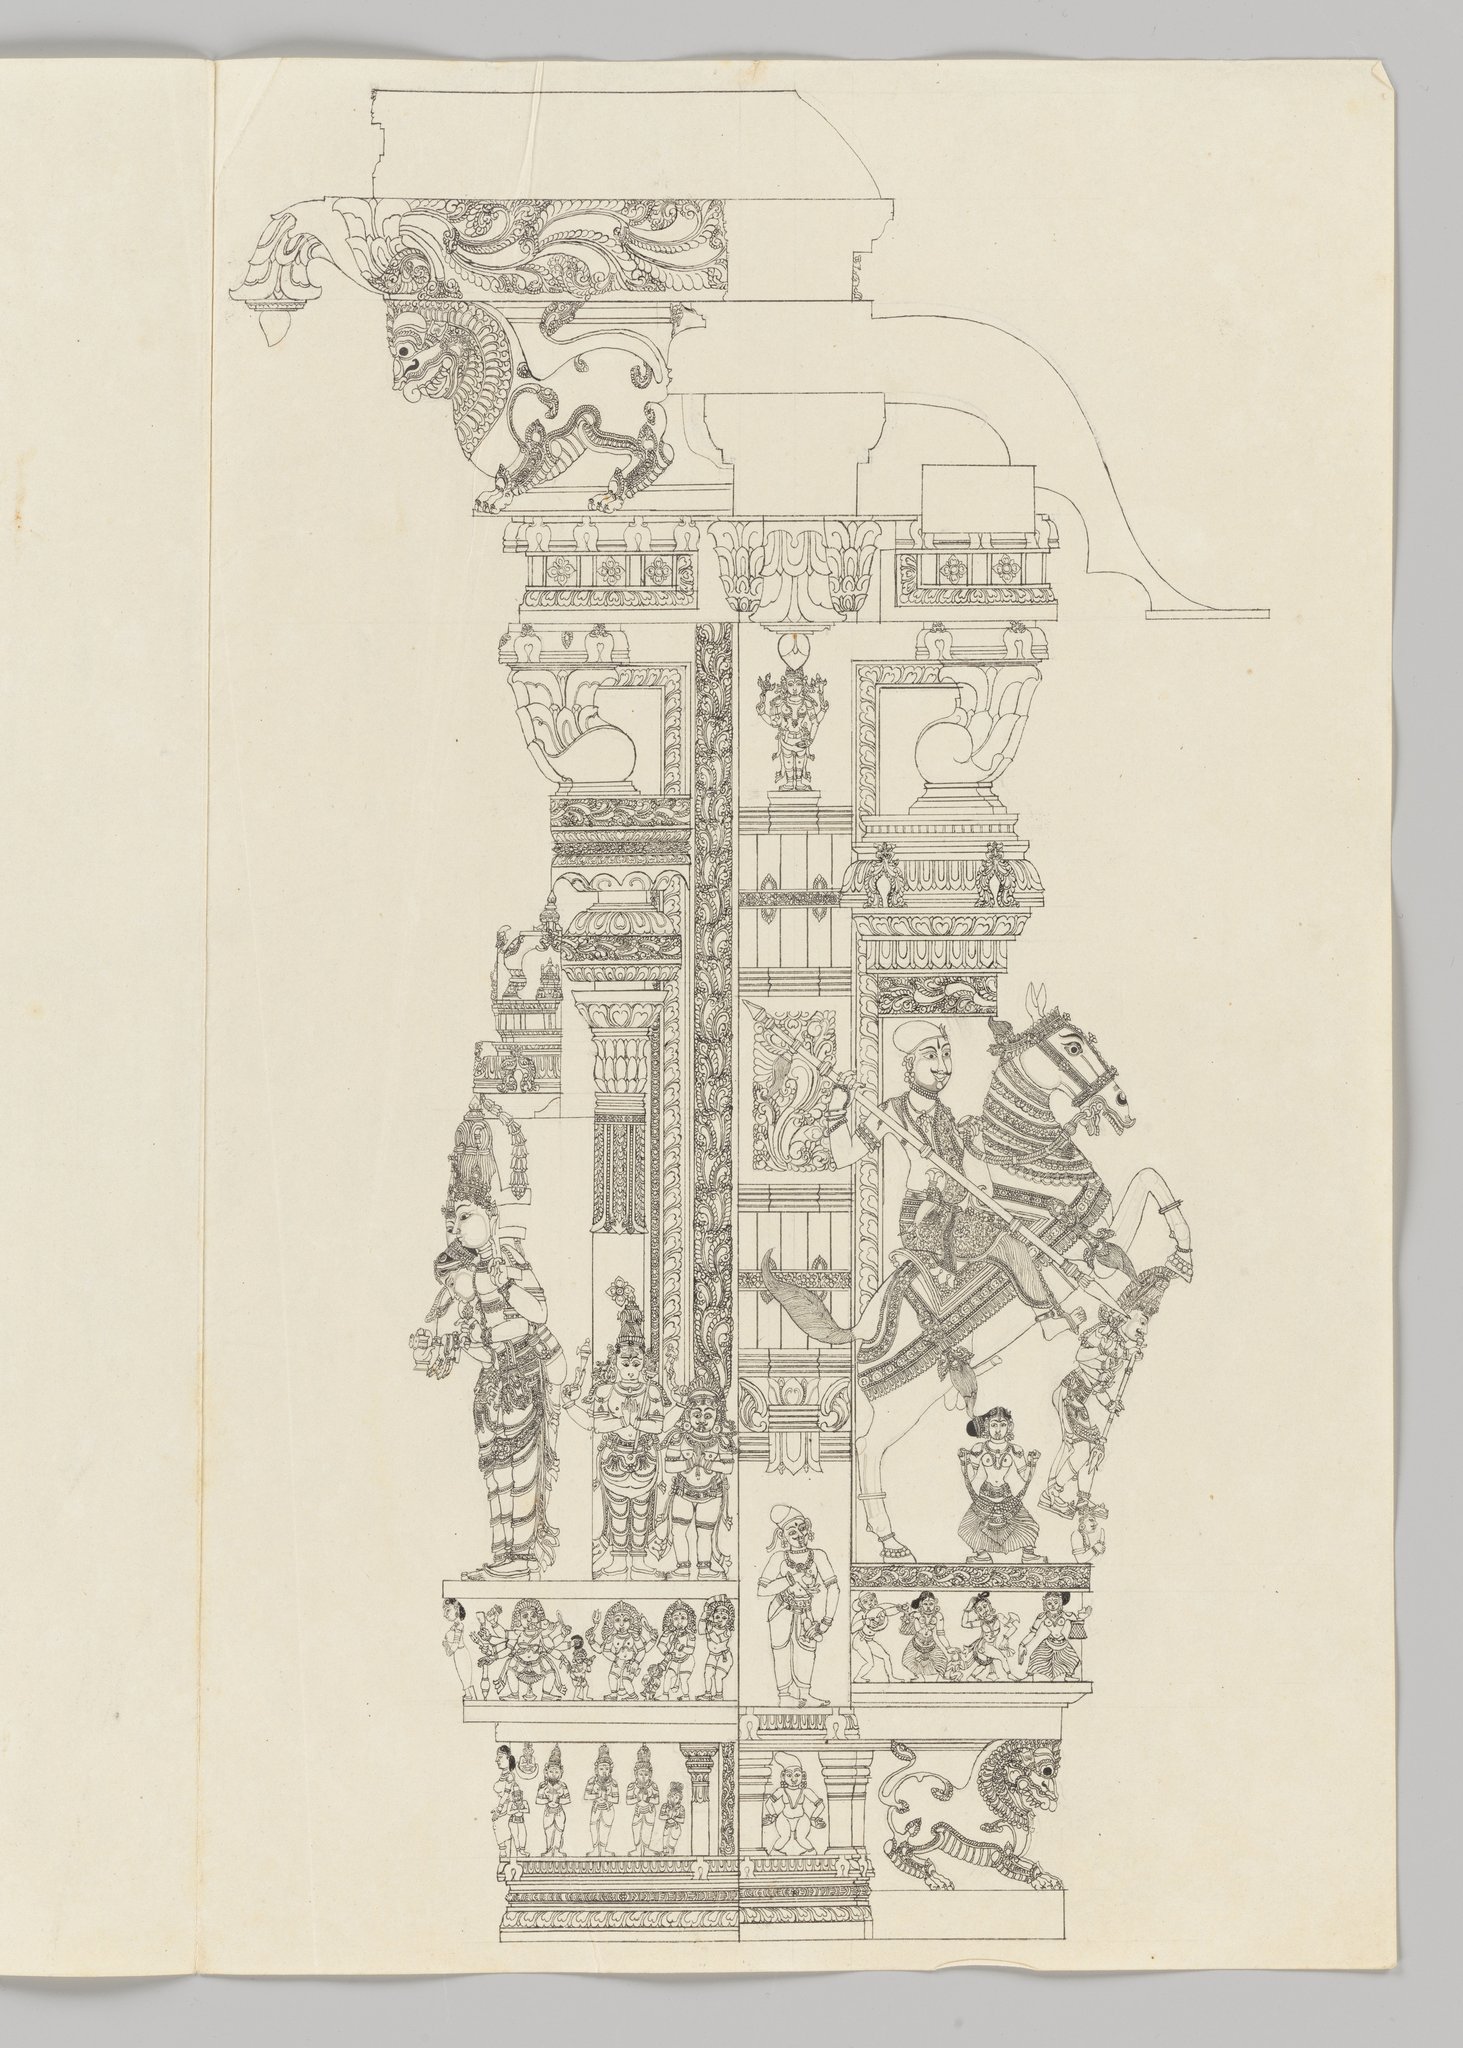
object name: drawing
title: Marriage of Minakshi and Sundareshvara; equestrian warrior with spear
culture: indian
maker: unidentified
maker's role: artist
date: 1800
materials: ink, paper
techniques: wash